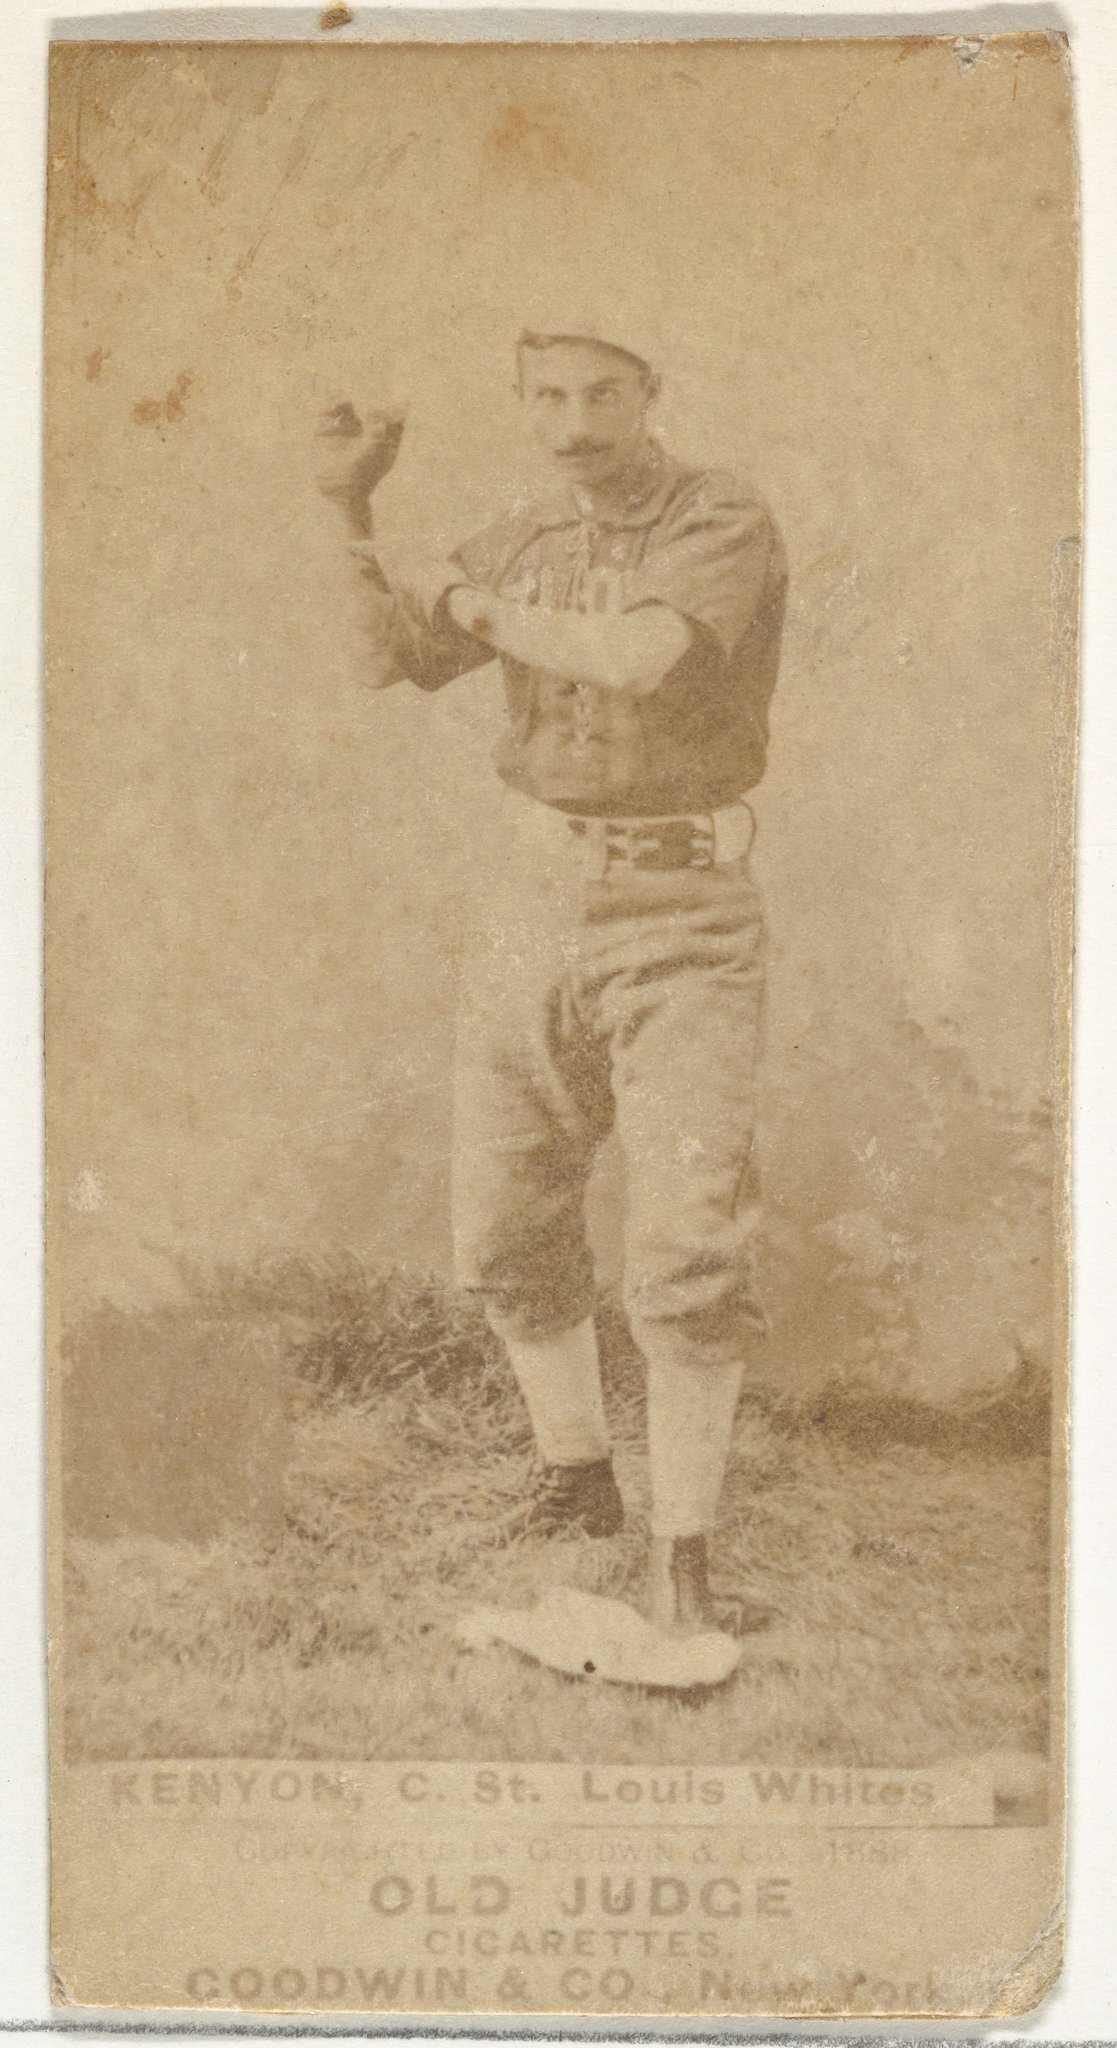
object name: baseball card, photograph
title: Kenyon, Catcher, St. Louis Whites, from the Old Judge series (N172) for Old Judge Cigarettes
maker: goodwin & company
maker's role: publisher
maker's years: 1850-1950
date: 1887-1890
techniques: albumen silver print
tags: men,portraits,baseball,athletes